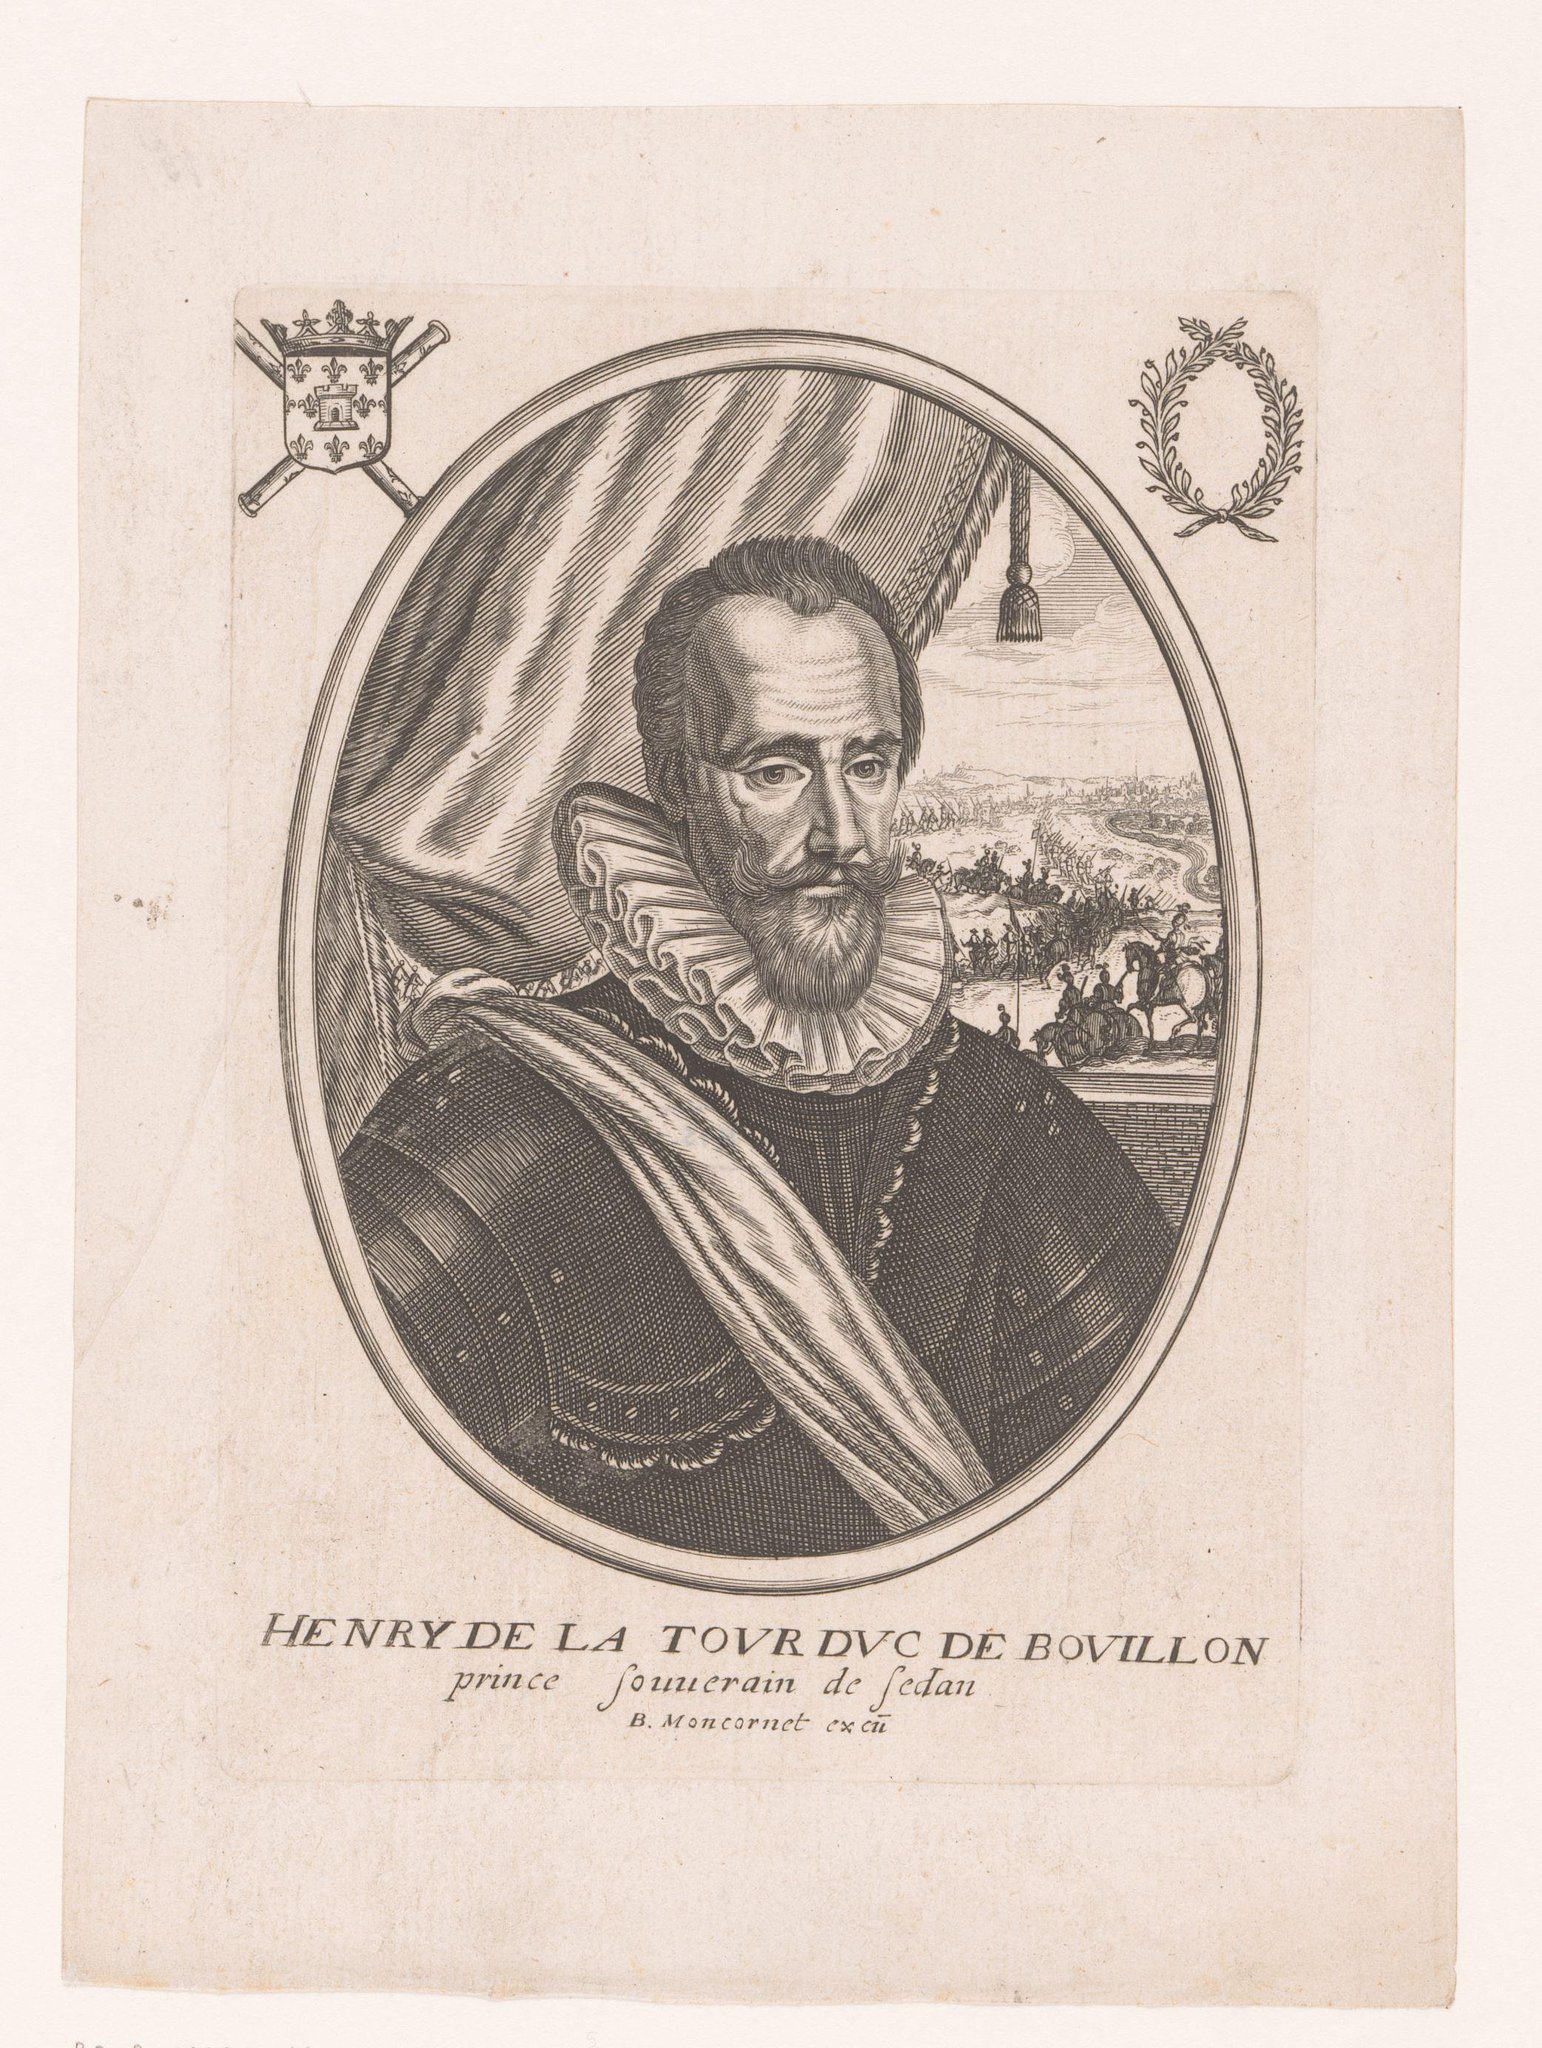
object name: print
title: Portret van Hendrik de La Tour d'Auvergne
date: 1610-1668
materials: paper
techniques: engraving, etching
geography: paris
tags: historical persons, diplomacy, diplomat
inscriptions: collector's mark: Lugt 2228